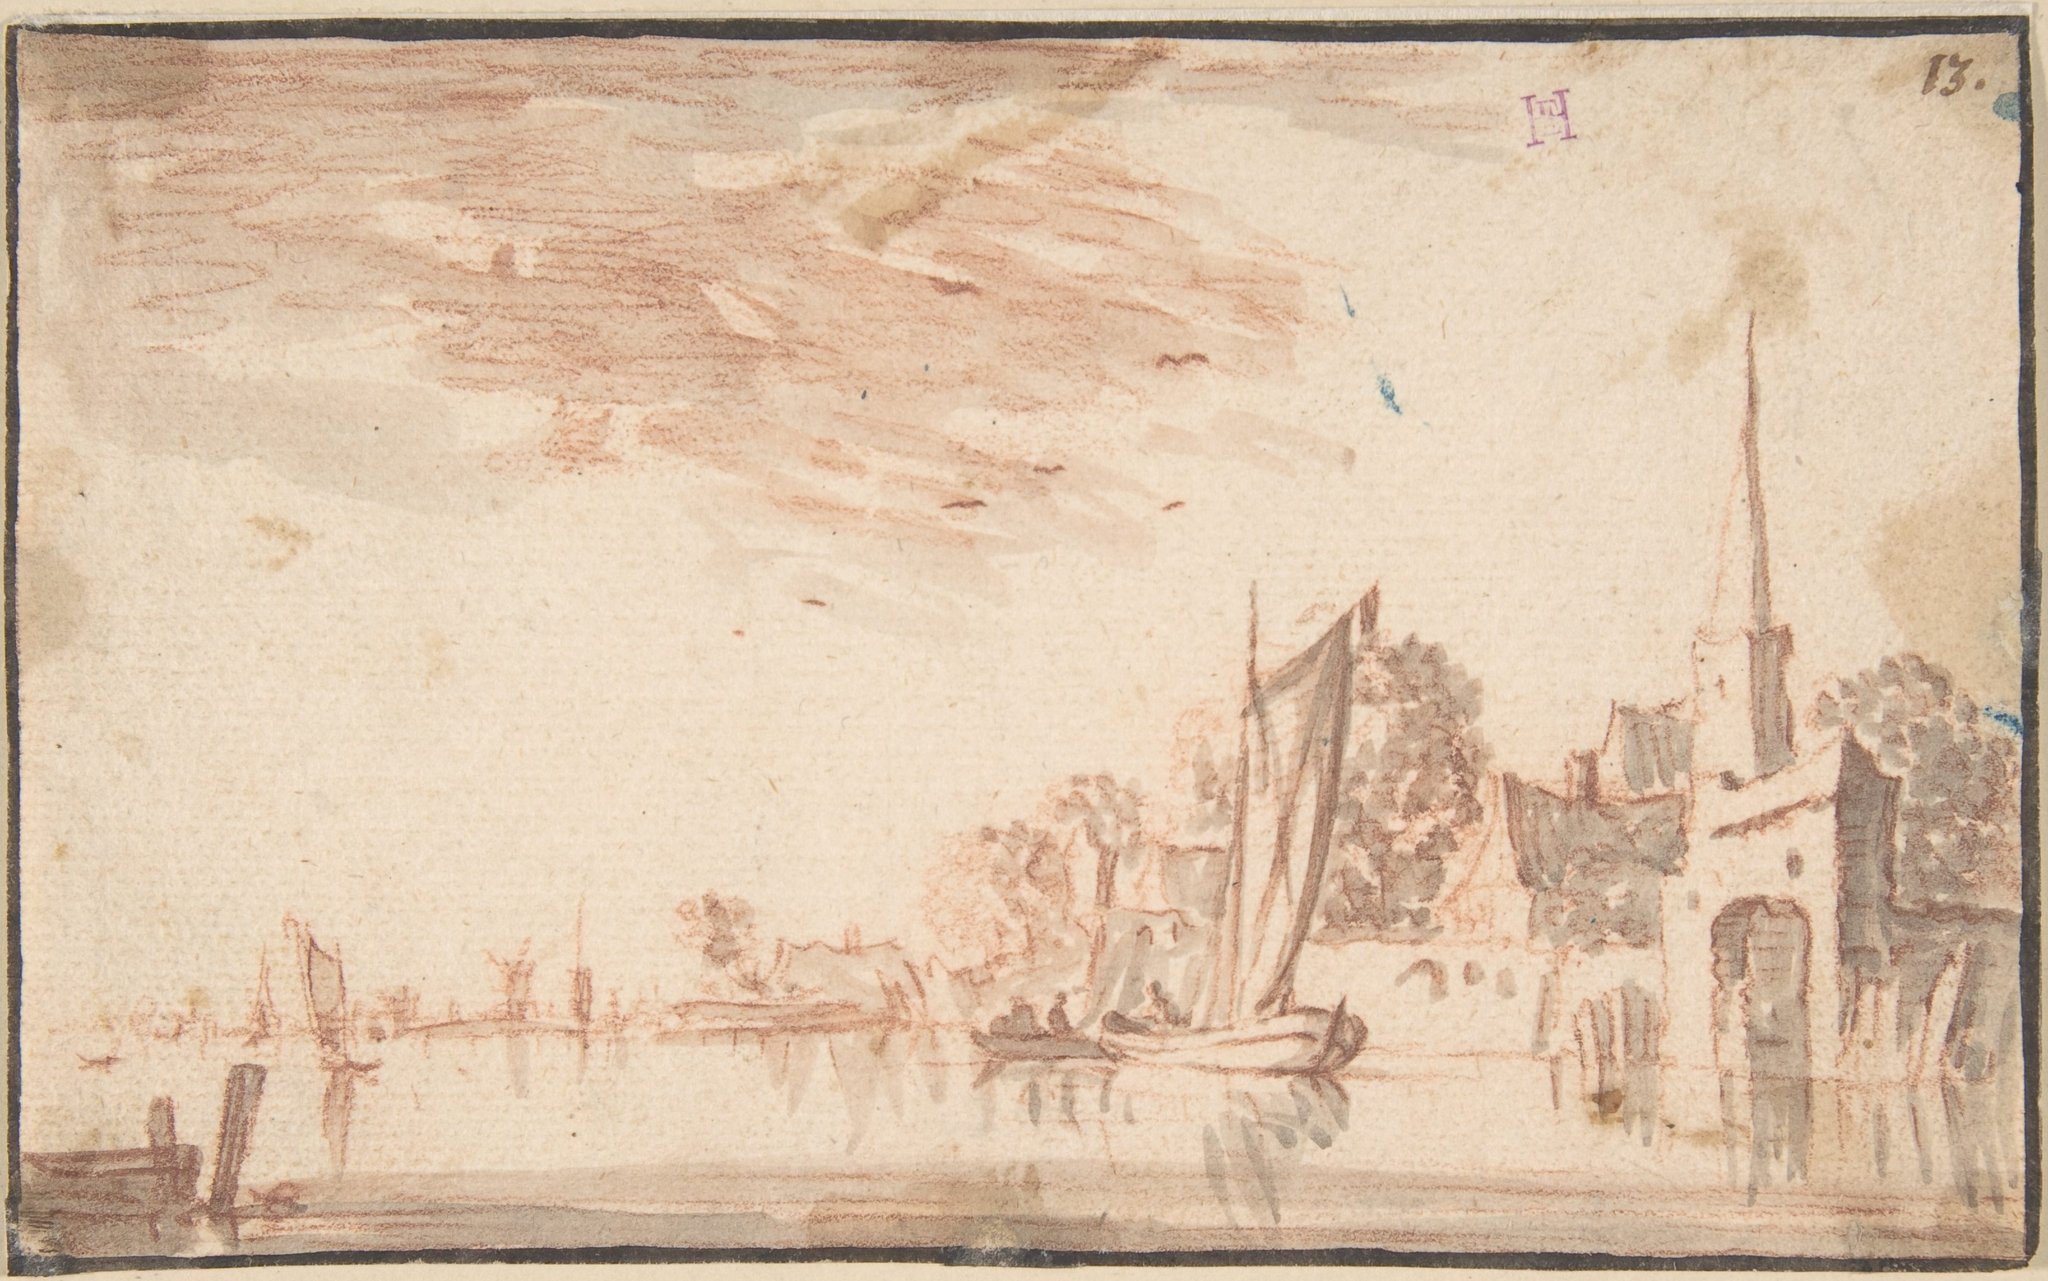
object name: drawing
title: River Scene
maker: anonymous, dutch, 17th century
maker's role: artist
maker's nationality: dutch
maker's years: 1600-1700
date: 1601-1700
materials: chalk, ink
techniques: wash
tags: rivers,trees,boats